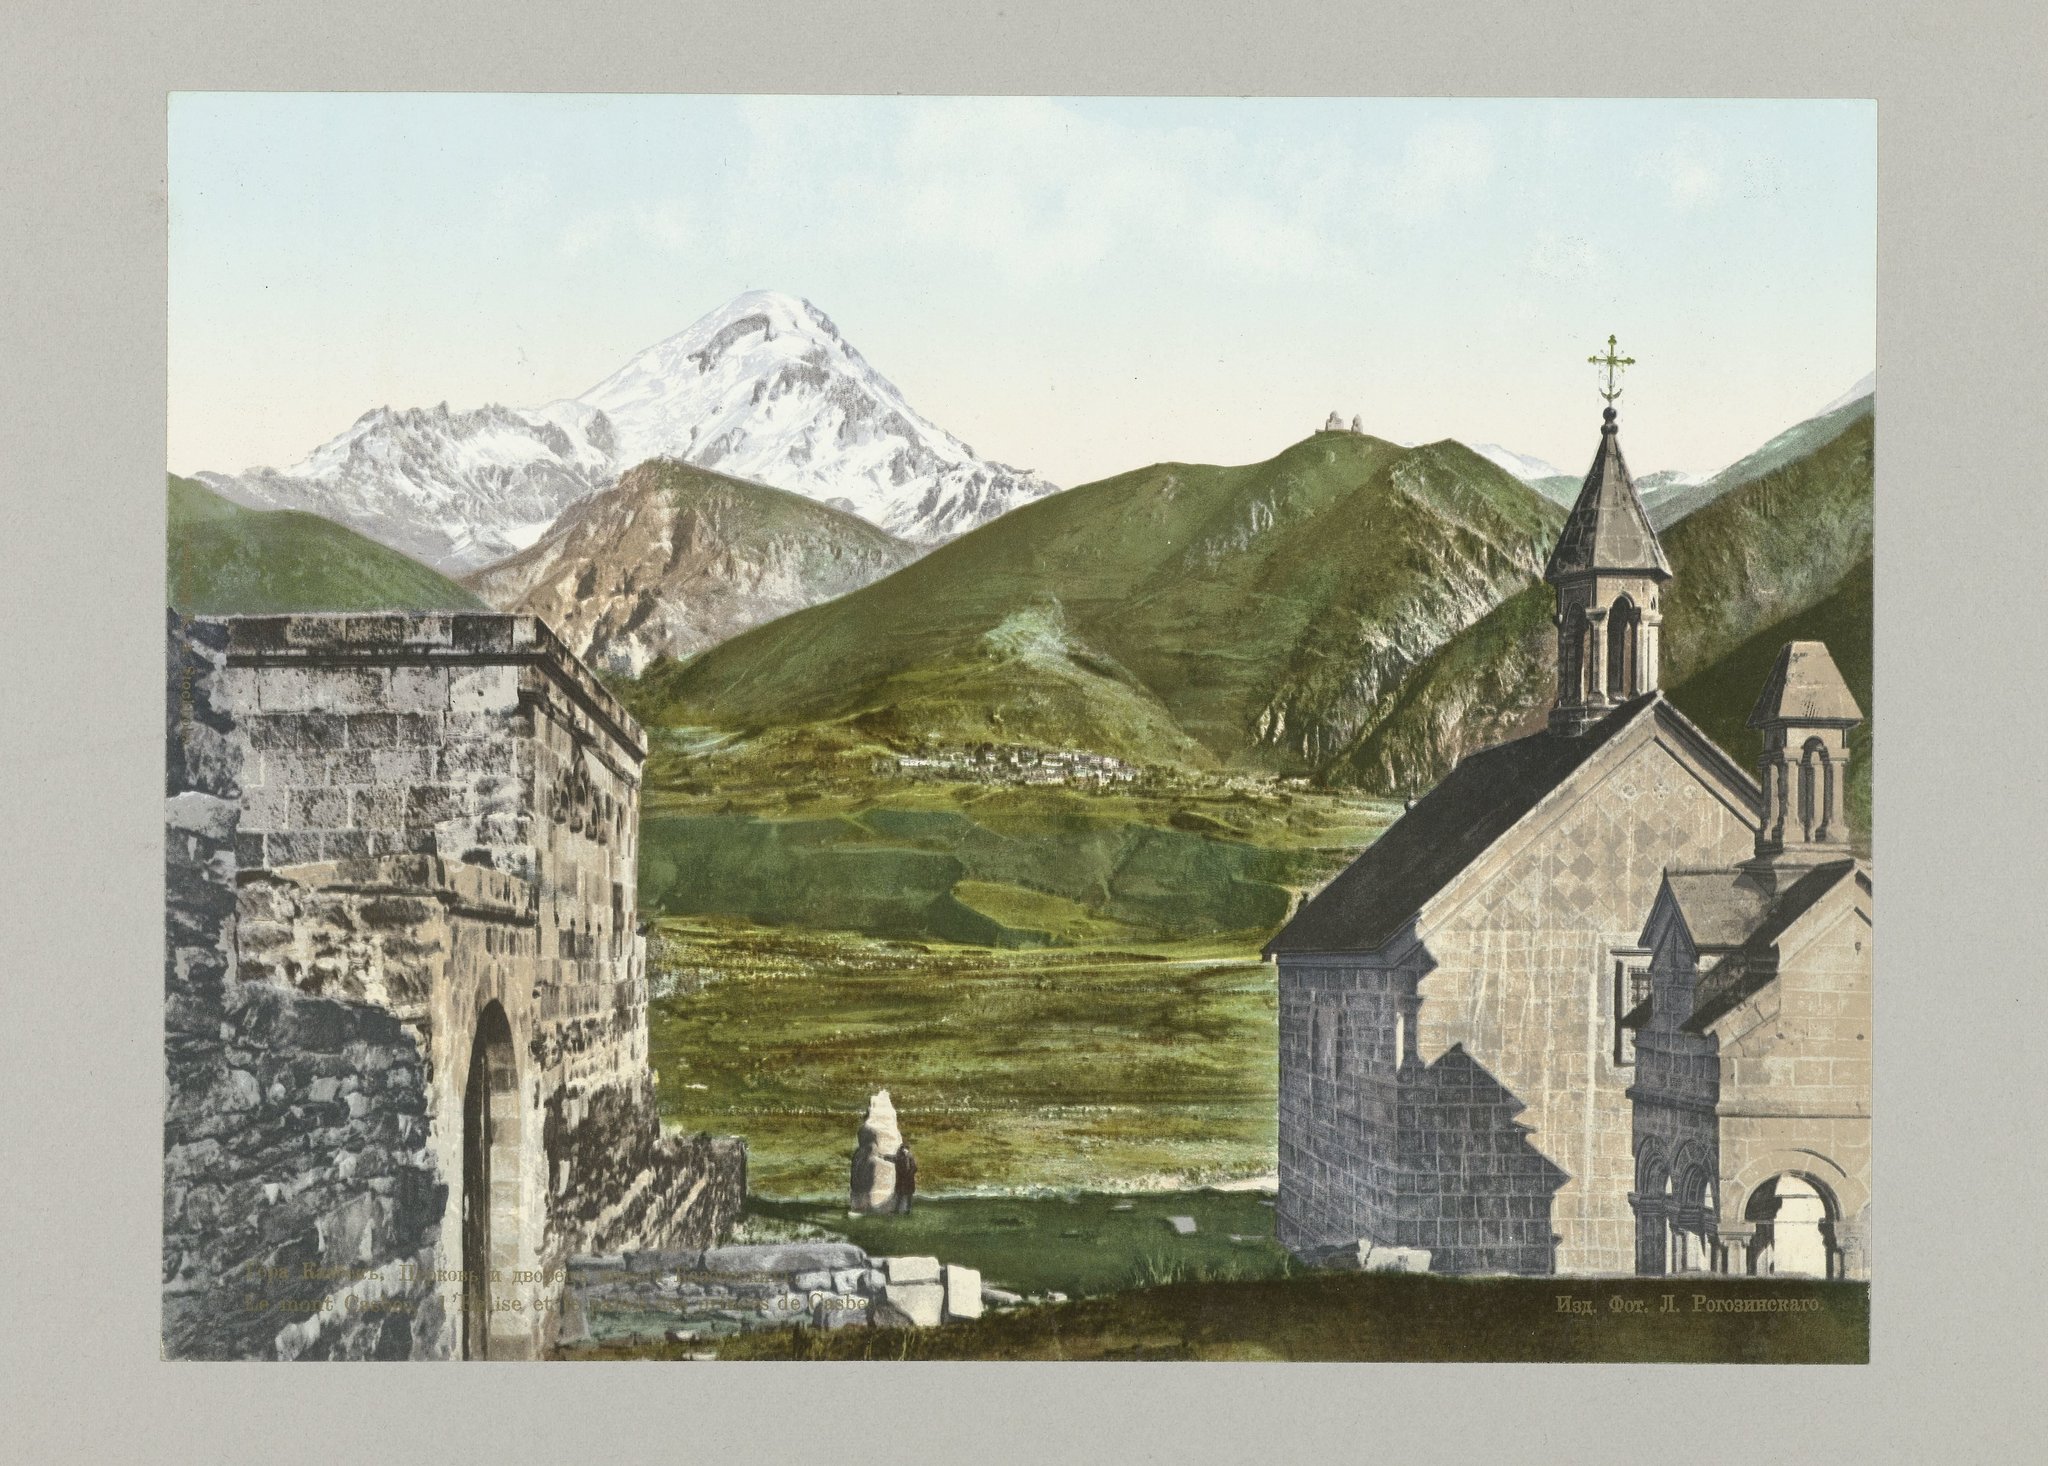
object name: photograph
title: Kerk en een kasteel bij de berg Kazbek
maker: Anonymous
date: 1895-1915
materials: cardboard, paper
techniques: photolithography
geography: georgia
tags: georgië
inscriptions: annotation: ‘36. Caucasus met Kazbek (M. 5043.)’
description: De berg Kazbek met op de voorgrond een kerk en het kasteel van de prinsen van Kazbek. Linksonder staat de titel in het Russisch en in het Frans.